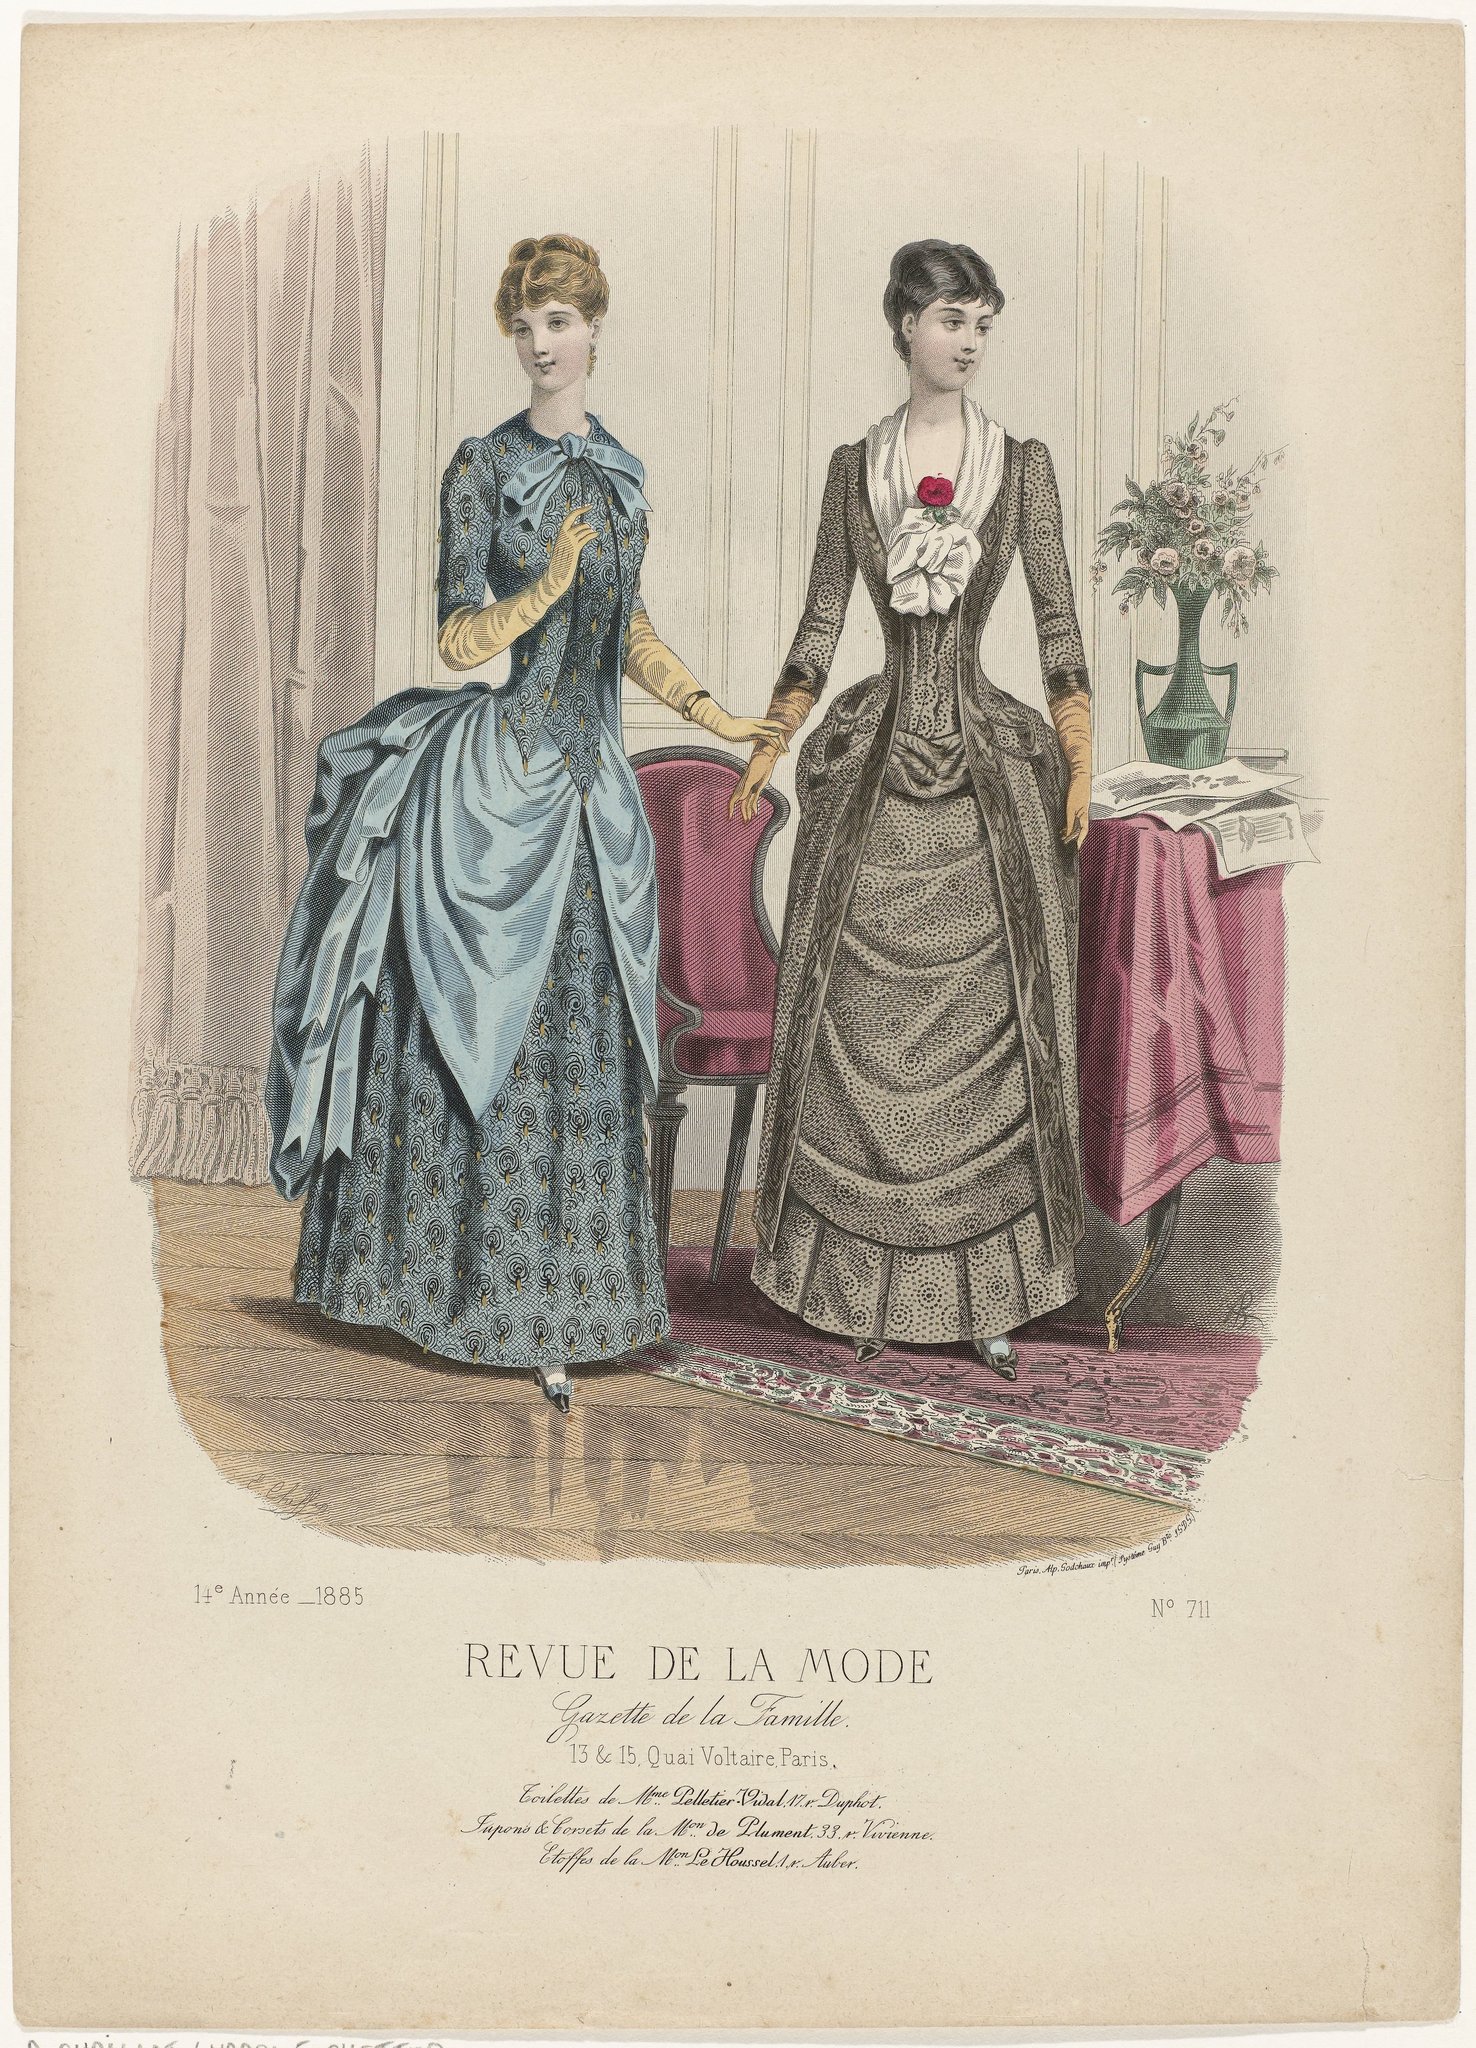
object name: fashion print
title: Revue de la Mode, Gazette de la Famille, 16 août 1885, 14e Année, No. 711 : Toilettes de Mme Pelletier-Vidal (...)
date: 1885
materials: paper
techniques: engraving, hand coloring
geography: paris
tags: bow (ornamental part of clothing) (+ women's clothes), corsage (+ women's clothes), flowers, gloves, mittens (long gloves) (+ women's clothes), fashion plates, skirt (+ women's clothes), dress, gown (+ women's clothes), flowers in a vase, piece of clothing covering the breast or décolleté (fichu) (+ women's clothes)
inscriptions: caption: ‘Toilettes de M.me Pelletier-Vidal, 17, r. Duphot. Jupons & Corsets de la M.on de Plument, 33, r. Vivienne. Etoffes de la M.on Le Houssel 1 r. Auber.’, title: ‘REVUE DE LA MODE / Gazette de la Famille’, address: ‘13 & 15, Quai Voltaire Paris’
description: Twee vrouwen in een interieur in japonnen van Pelletier-Vidal. Links: lichtblauwe japon met cirkelmotief, effen lichtblauwe overrok versierd met linten. Rechts: lichtbruine japon met stippel- en cirkelmotief. Fichu met strik en bloemcorsage. Met enkele regels reclametekst voor verschillende producten. Prent uit het modetijdschrift Revue de la Mode (1872-1913).